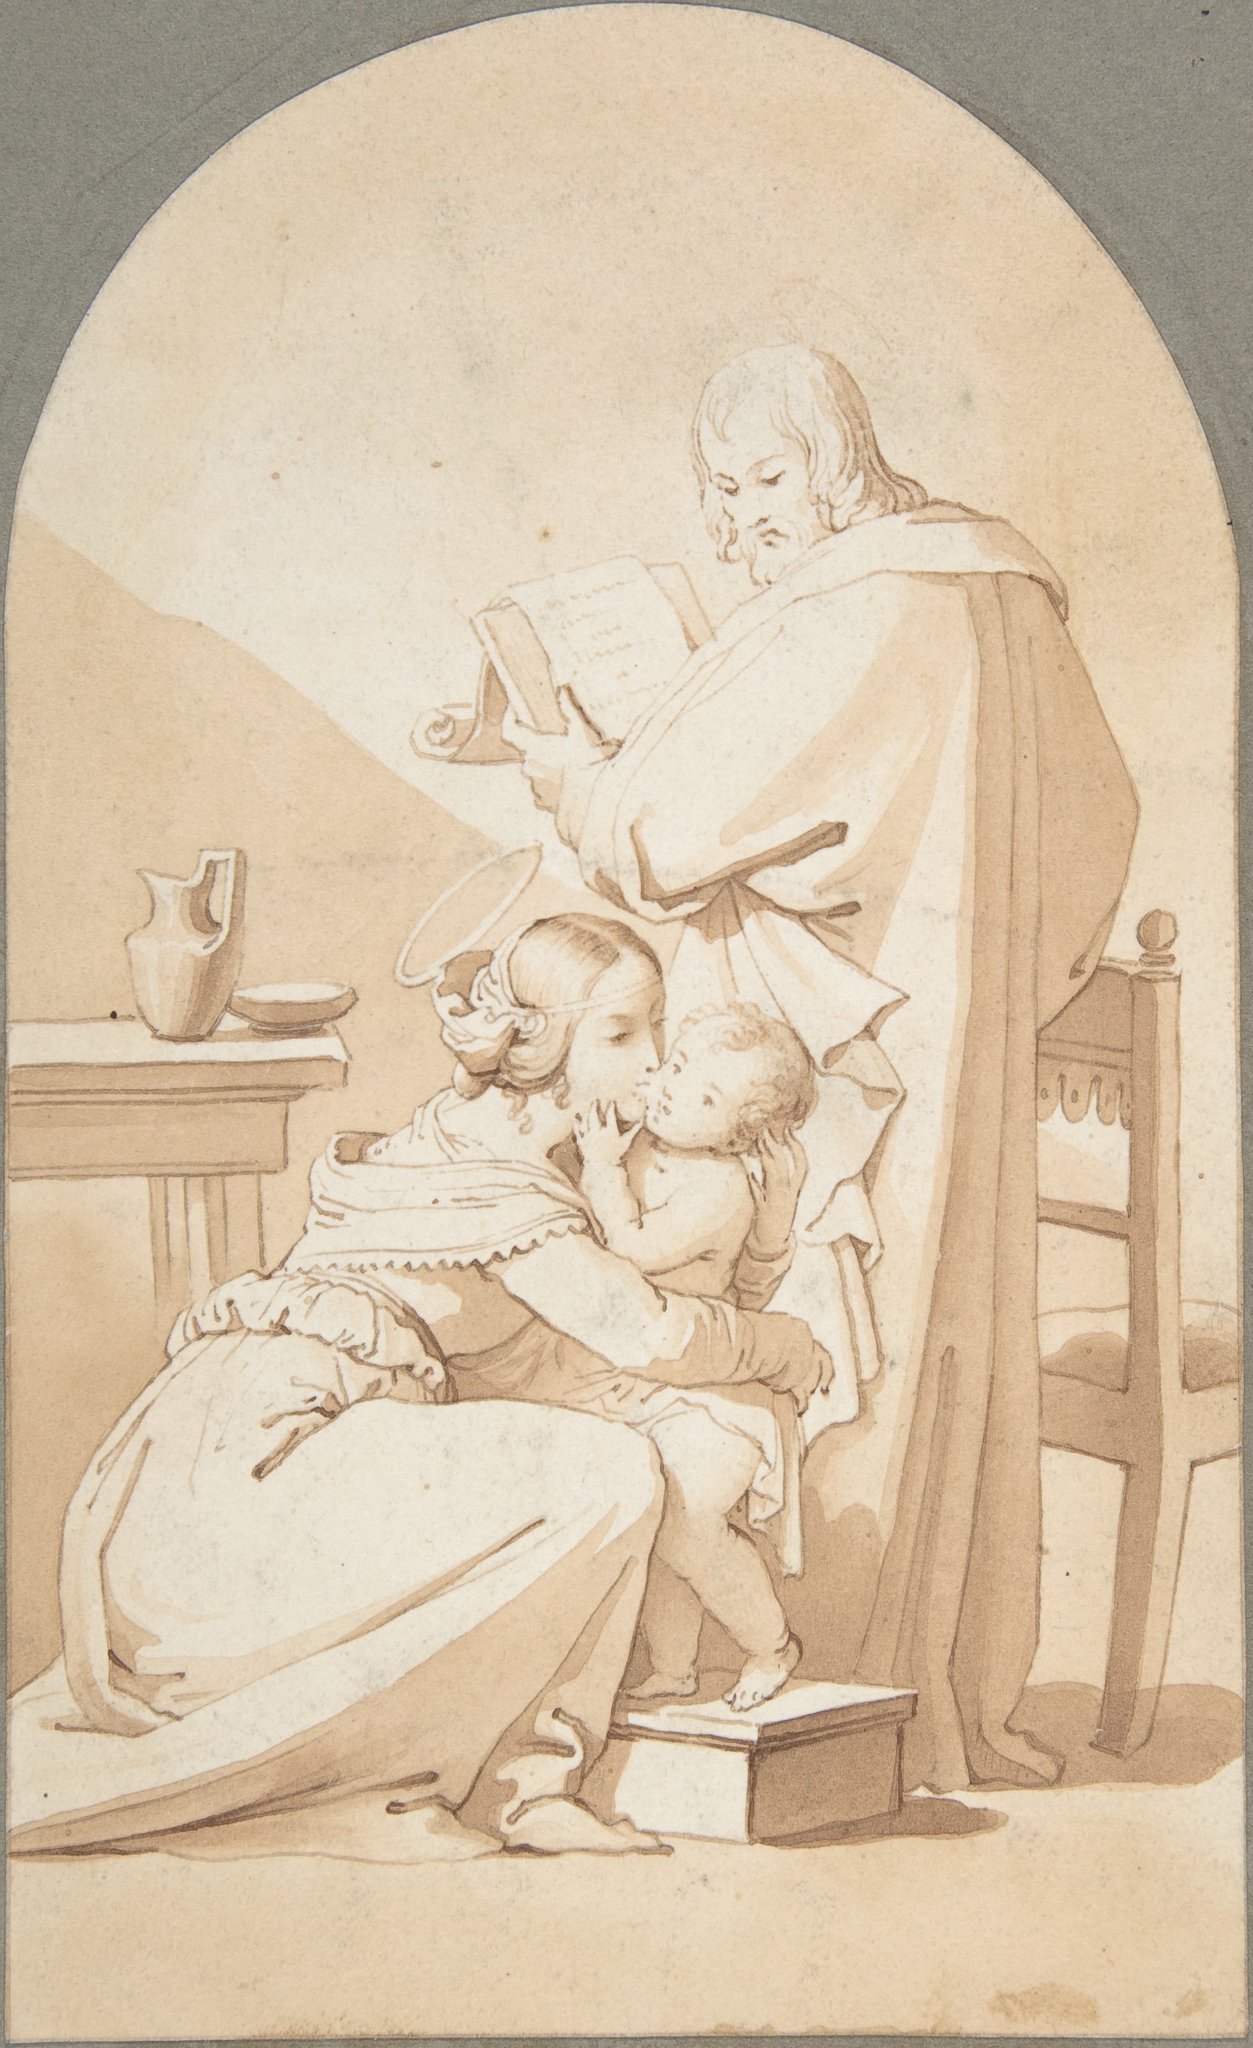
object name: drawing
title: The Holy Family in an Interior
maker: e. la touche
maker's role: artist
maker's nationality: french?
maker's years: 19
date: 1801-1833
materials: ink, paper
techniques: pen, wash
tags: christ,holy family,saint joseph,virgin mary